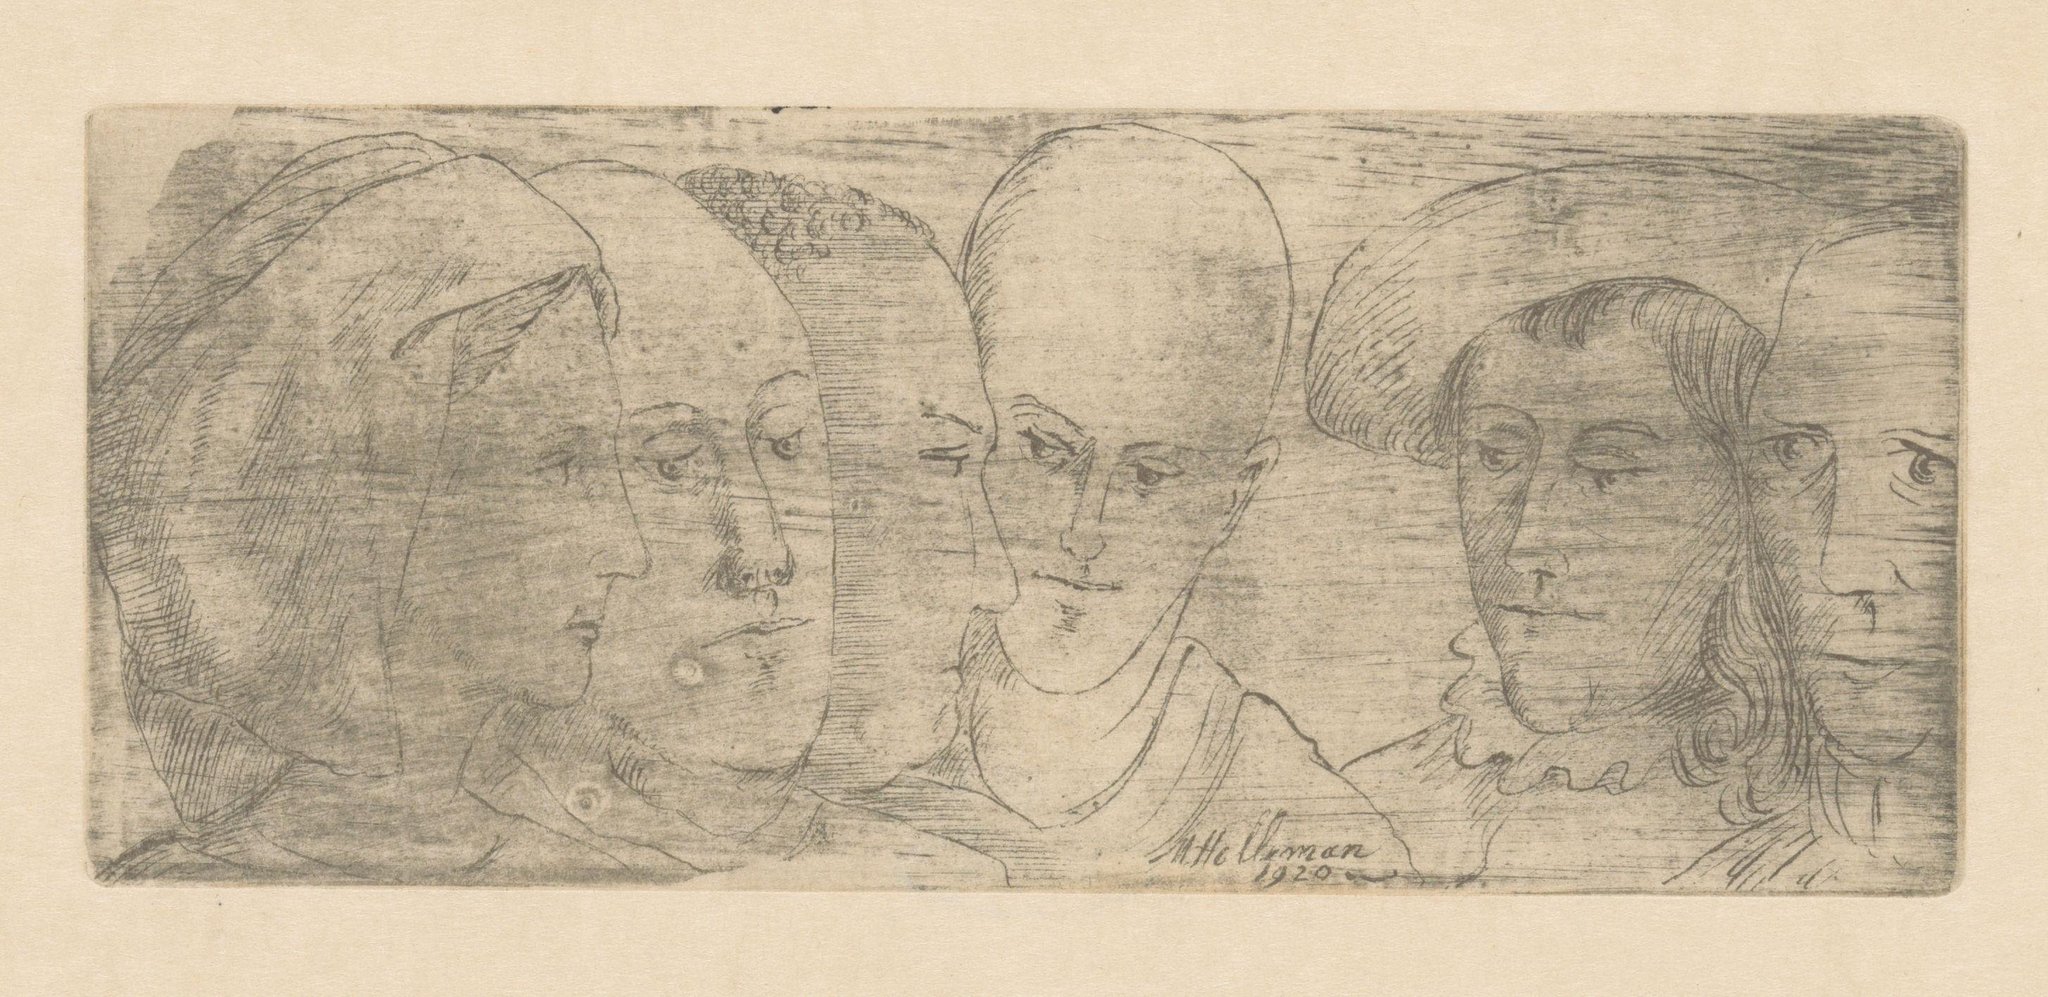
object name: print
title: Vrouw met hoofddoek en vijf mannen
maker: marius holleman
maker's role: draughtsman, print maker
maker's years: 1878-1926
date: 1920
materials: paper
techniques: etching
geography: groningen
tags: head-gear (with name), head-gear: hat, baldness, neck-gear: collar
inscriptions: collector's mark: Lugt 2228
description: Links de vrouw. In het midden een man met een kaal hoofd, rechts van hem een man met hoed en kraag.